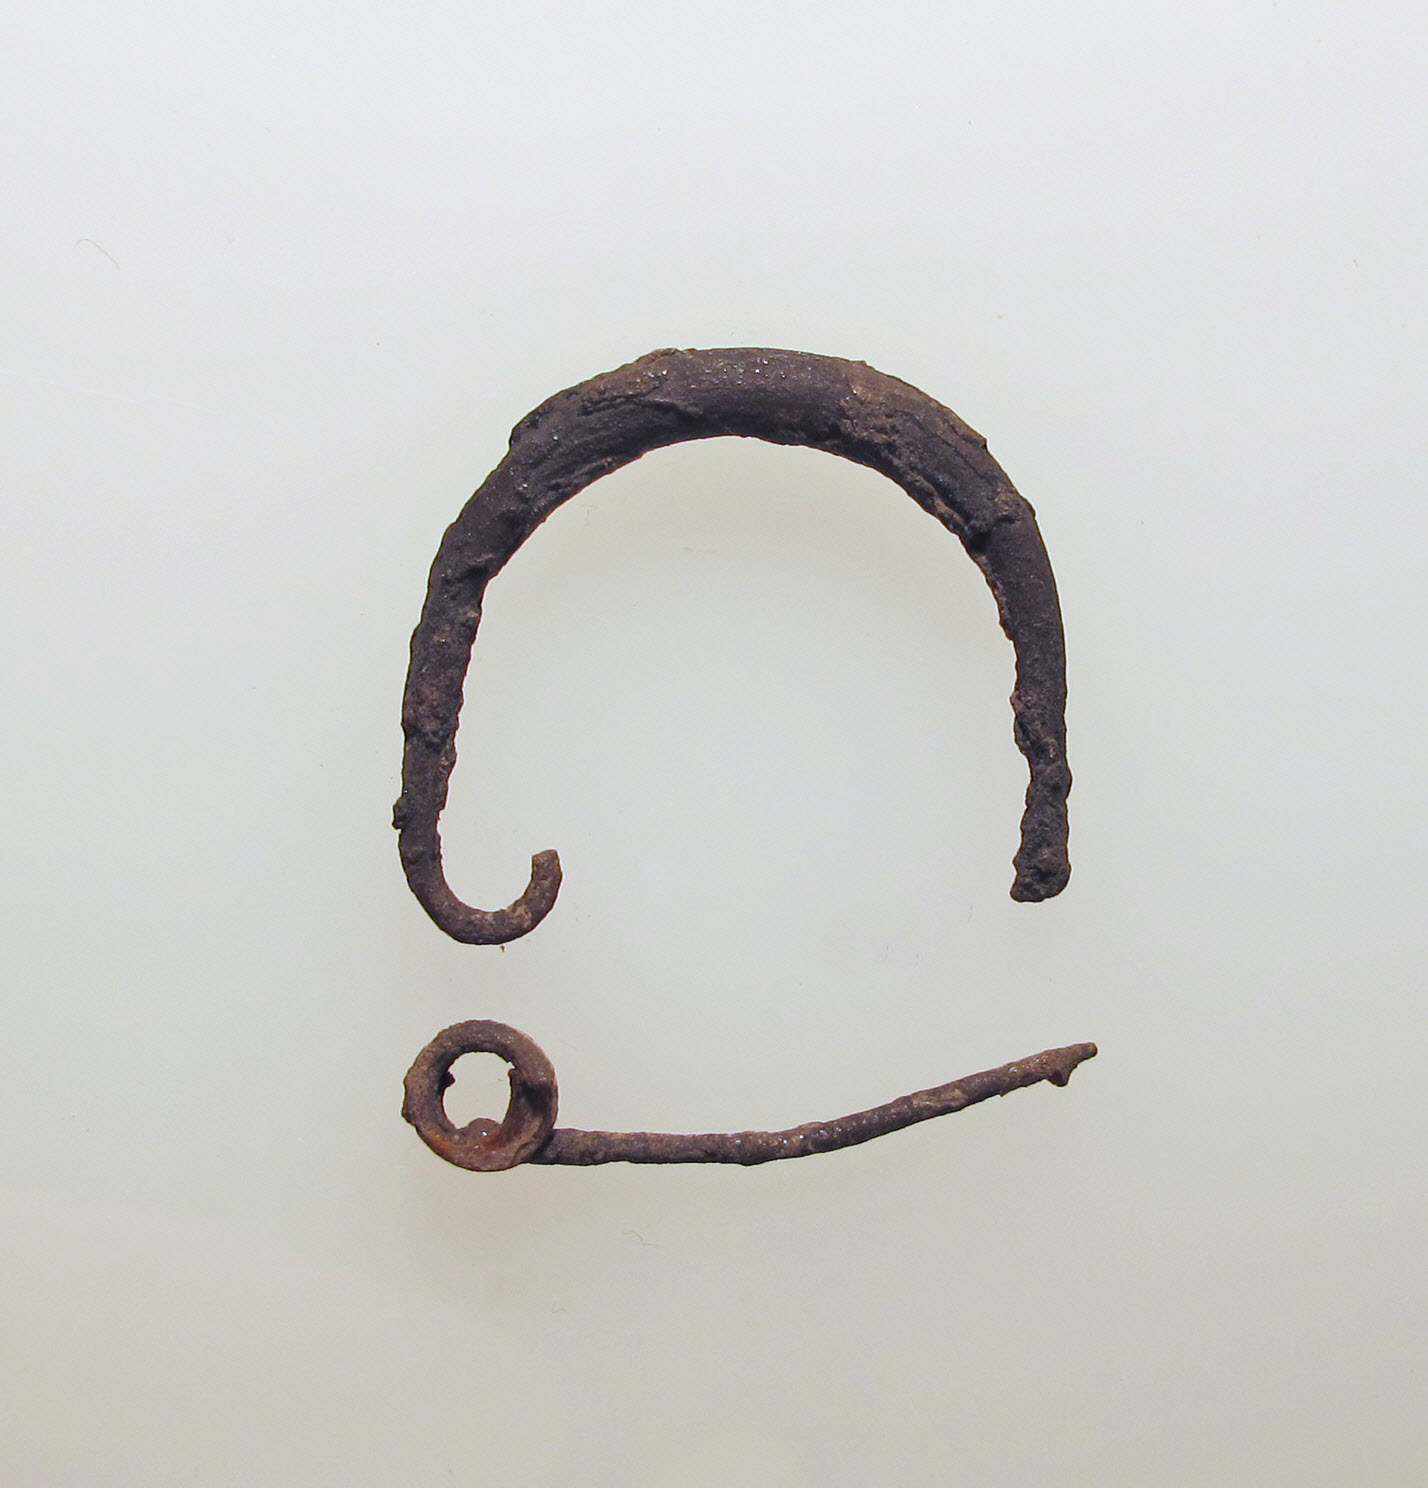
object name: fibula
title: Silver fibula (safety pin)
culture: cypriot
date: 3900 BCE-100 CE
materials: silver